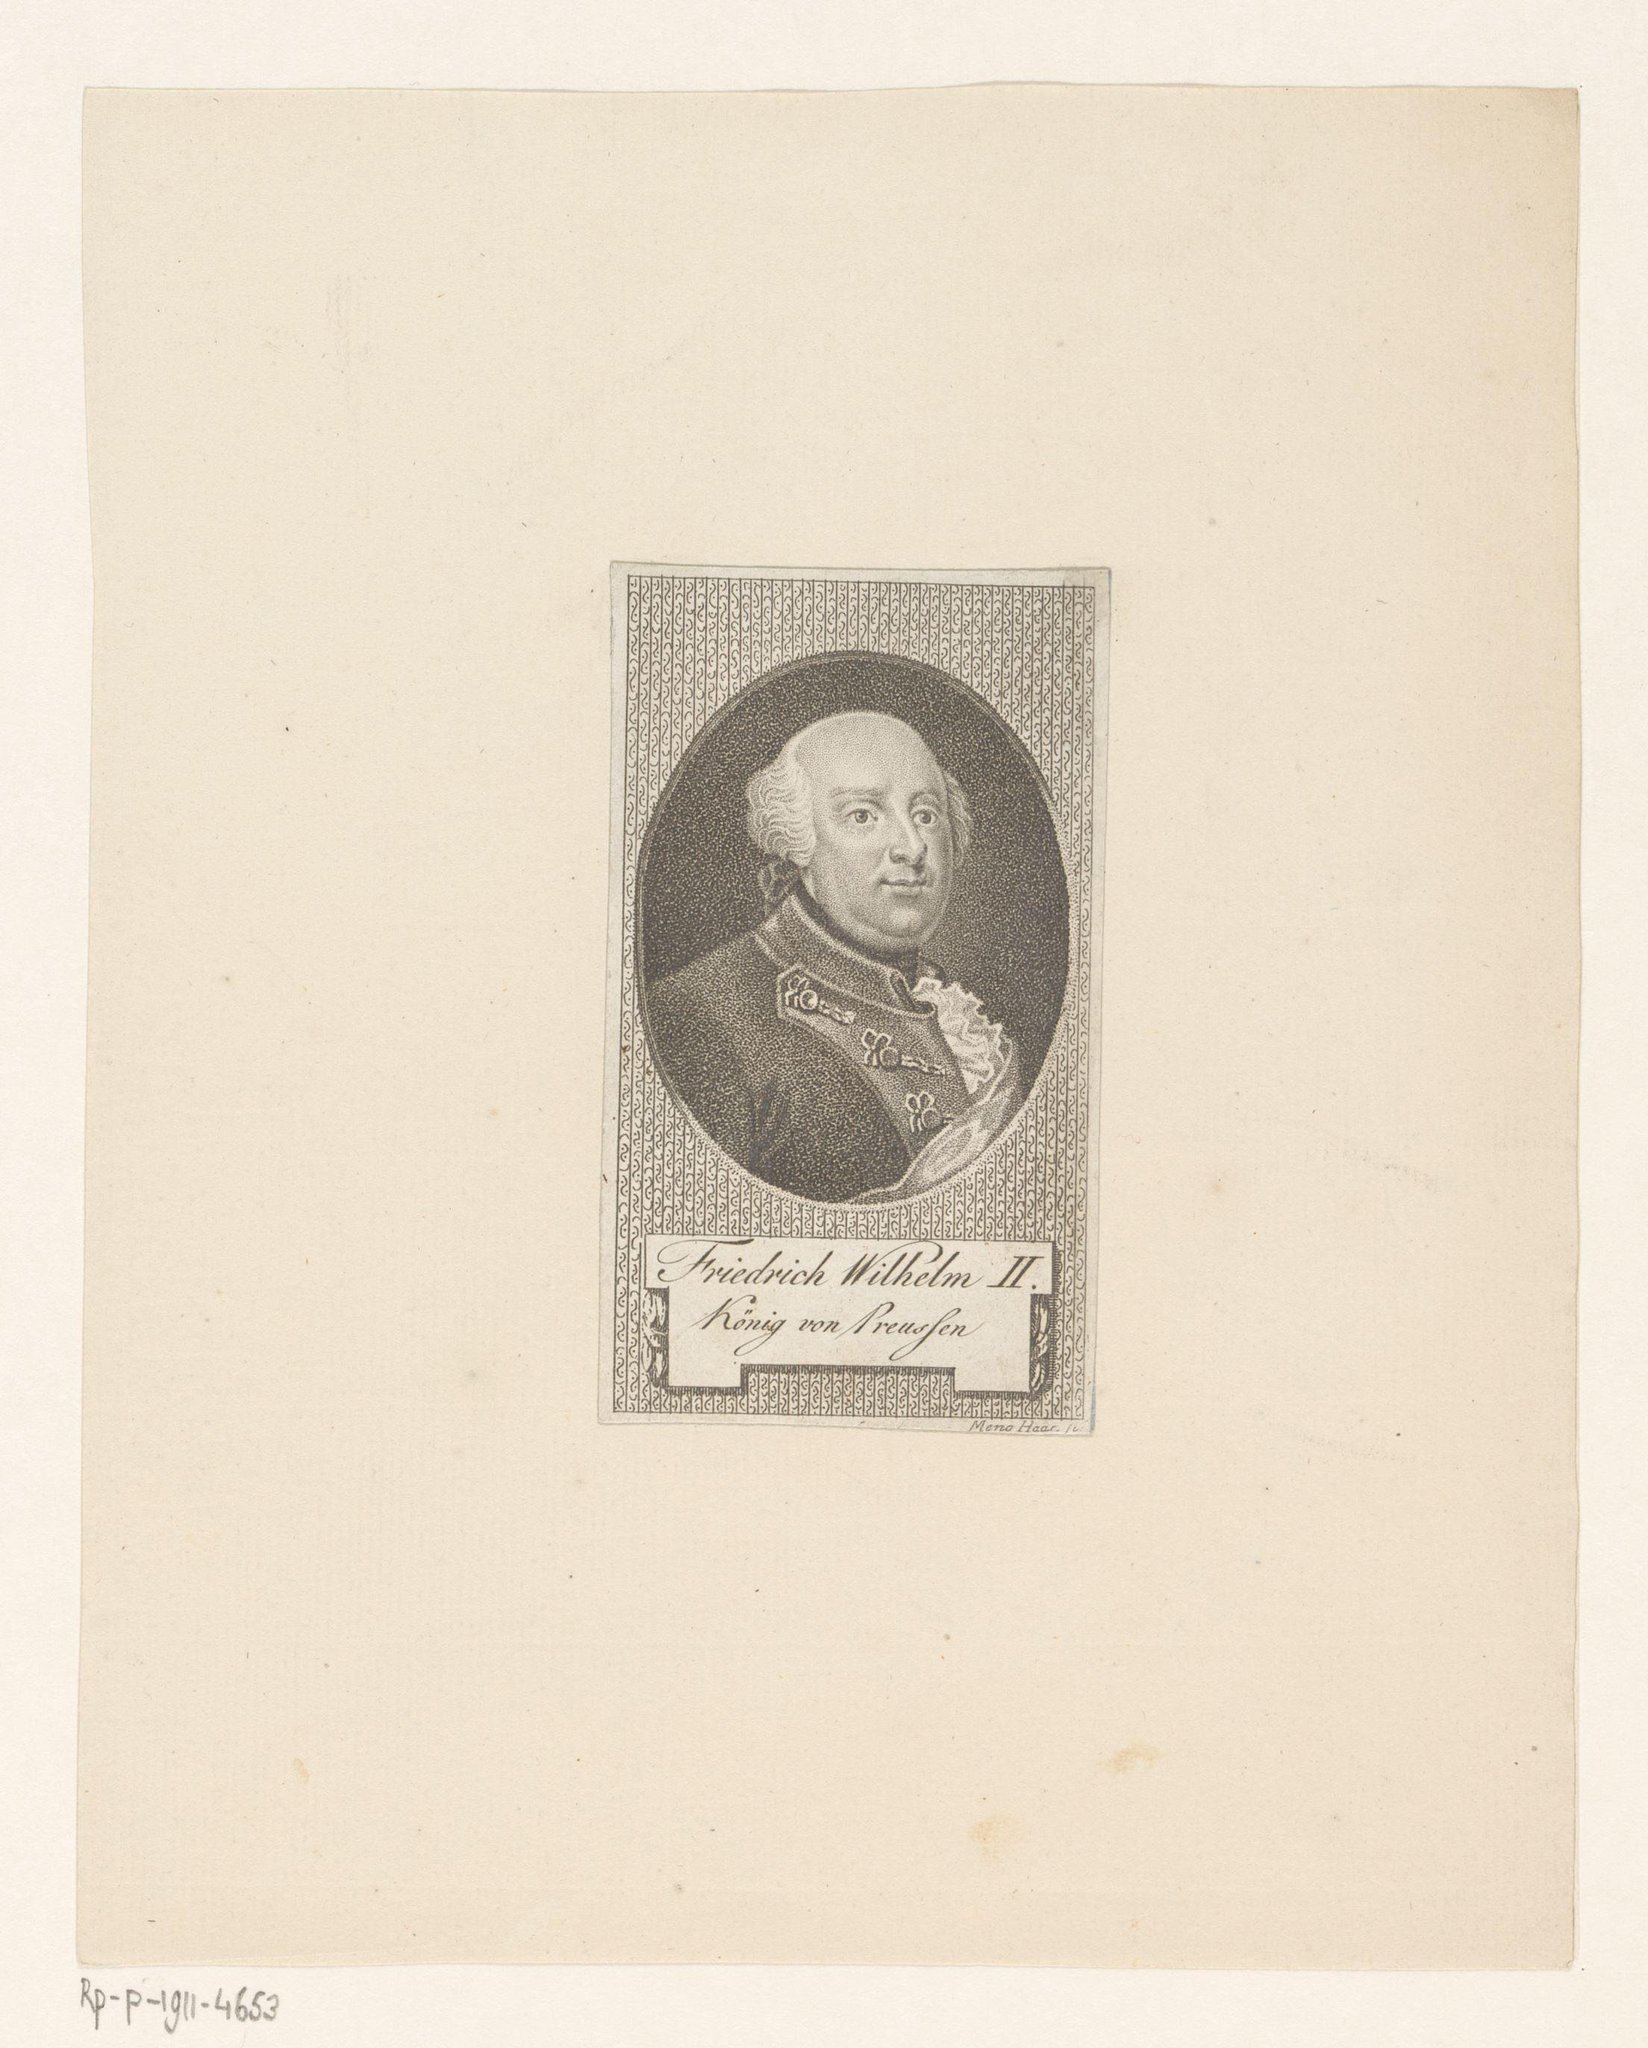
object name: print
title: Portret van Frederik Willem II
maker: meno haas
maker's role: print maker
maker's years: 1752-1833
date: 1762-1797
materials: paper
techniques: etching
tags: frederik willem ii (koning van pruisen)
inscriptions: collector's mark: Lugt 2228